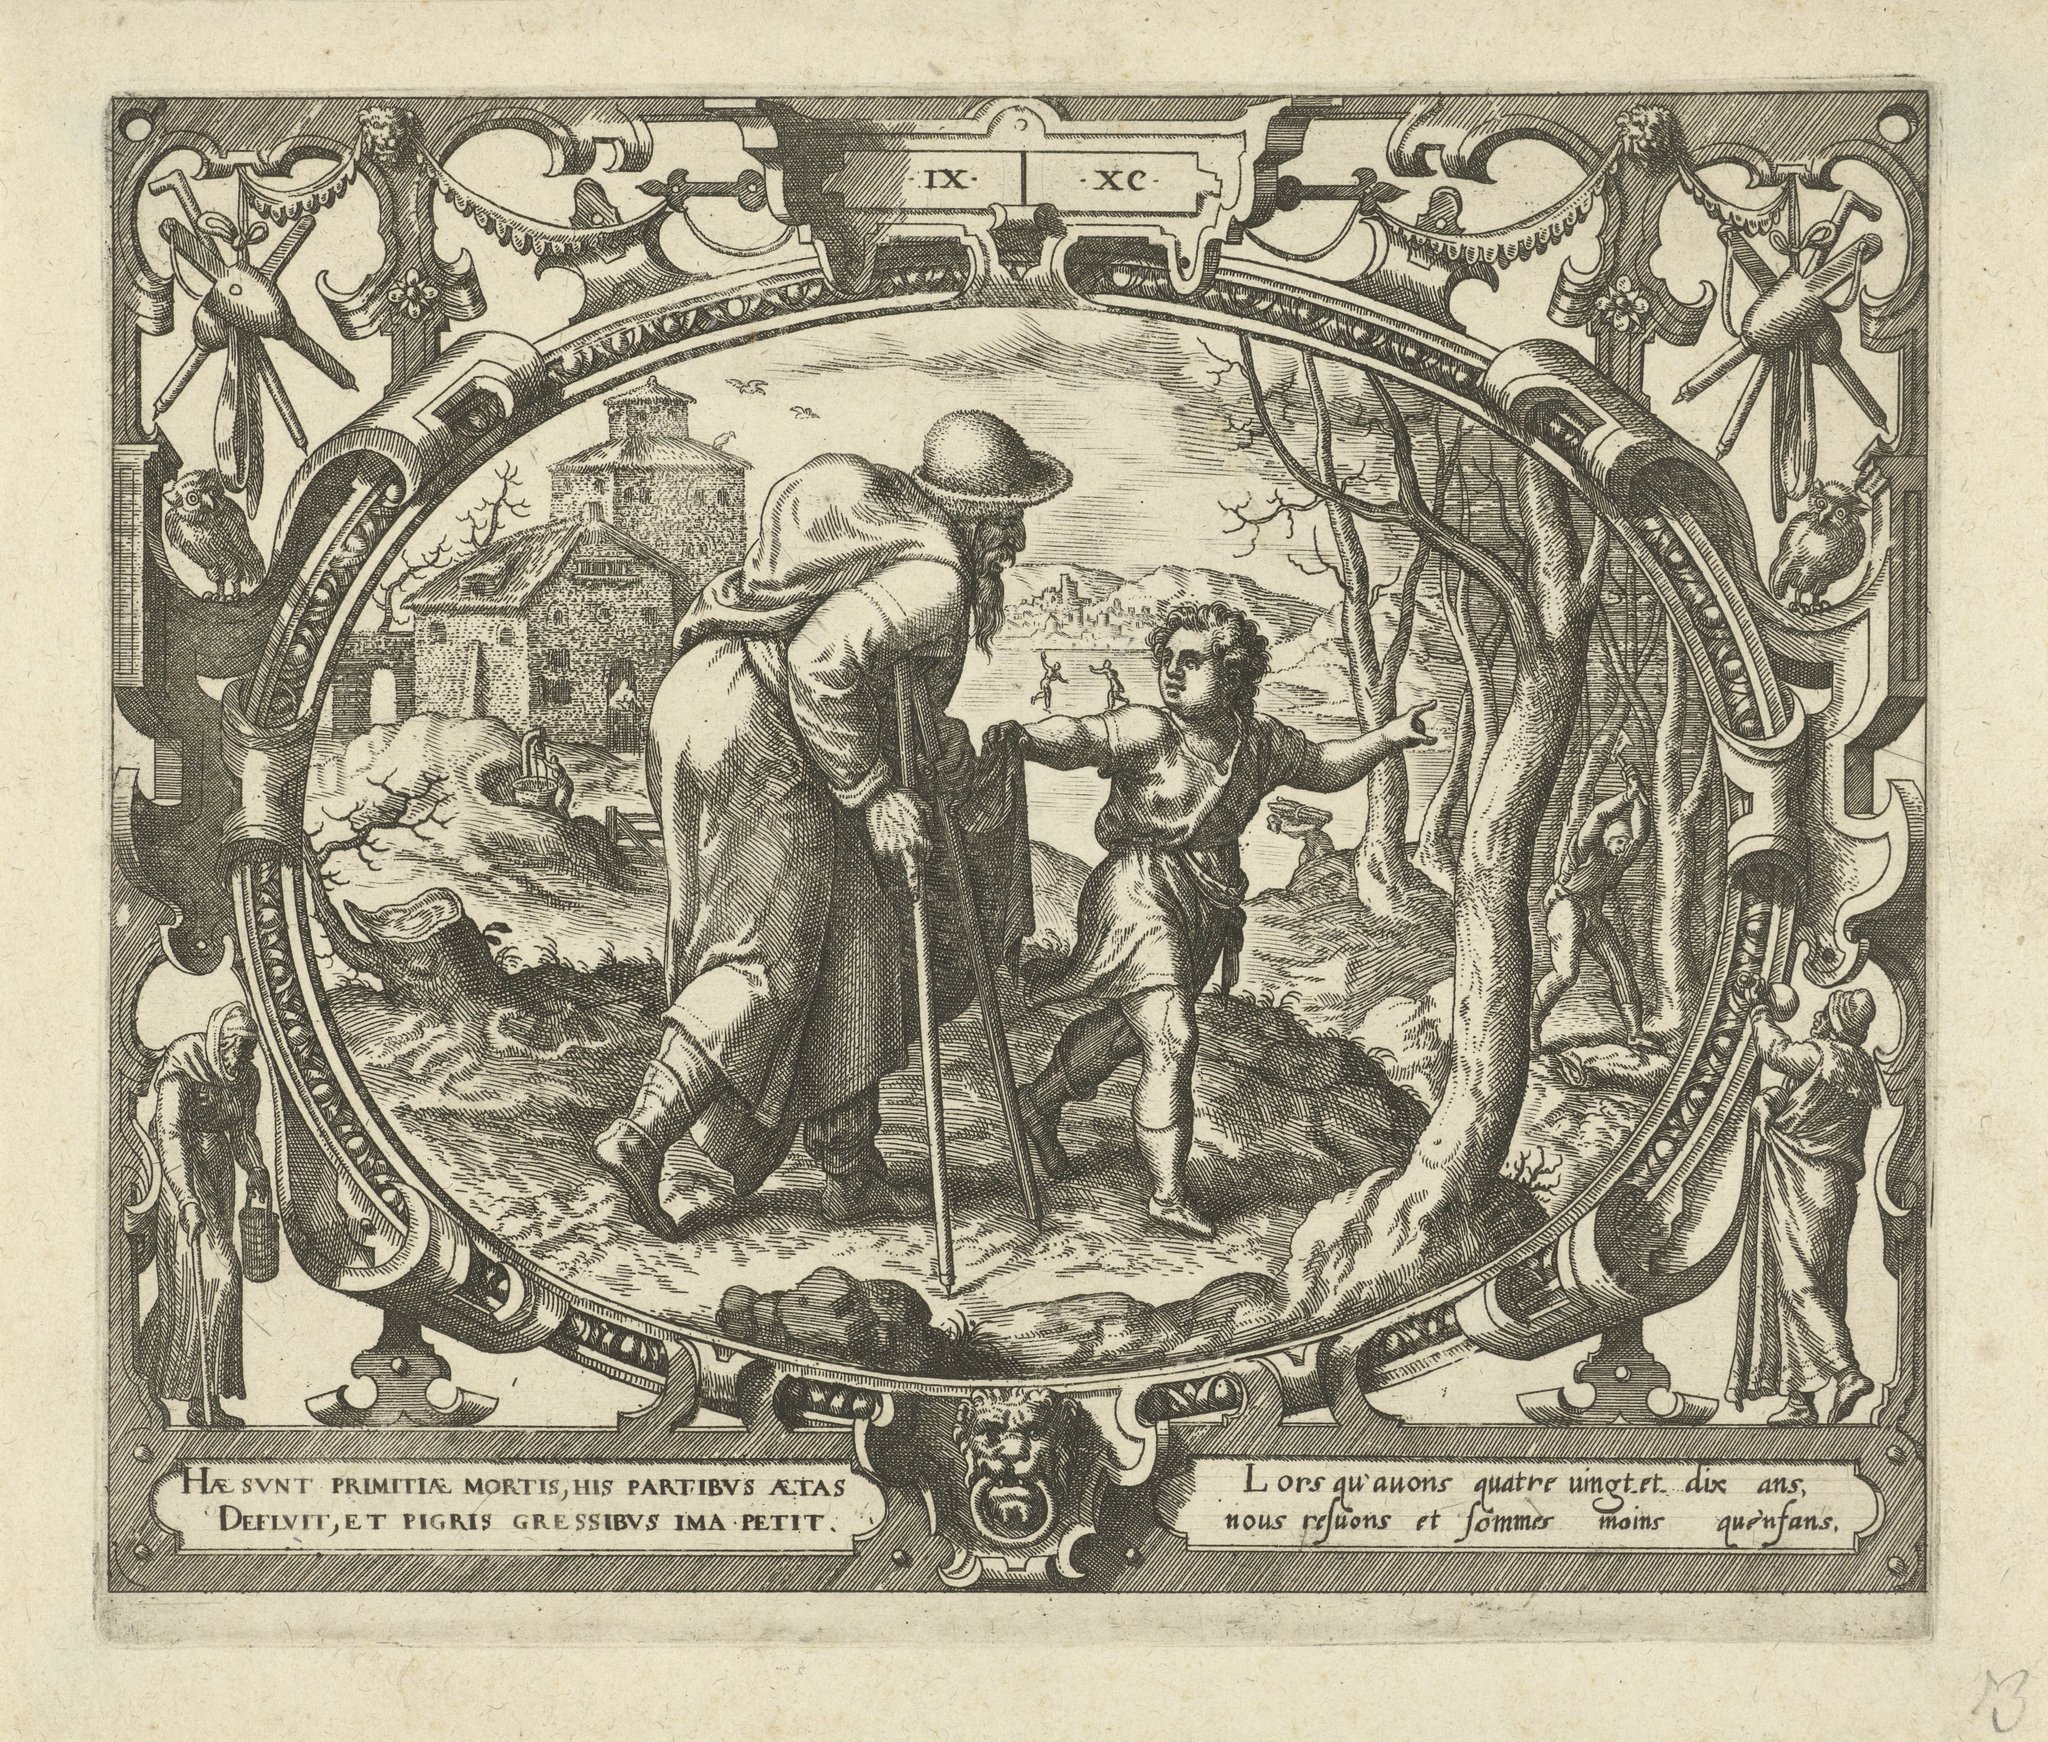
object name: print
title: Tien leeftijden van de mens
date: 1569-1575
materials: paper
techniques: engraving, etching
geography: antwerp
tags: crutches, woodcutting, woodcutter ~ forestry, old man, winter landscape; landscape symbolizing winter (the four seasons of the year), hunchback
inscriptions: collector's mark: Lugt 2228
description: In een ovaal kader versierd met ornamenten een voorstelling van een oude gebochelde man die op twee krukken loopt en zich laat leiden door een jongen. De jongen wijst naar een houthakker. Op de achtergrond een winterlandschap. De prent heeft een Latijns en Frans onderschrift.